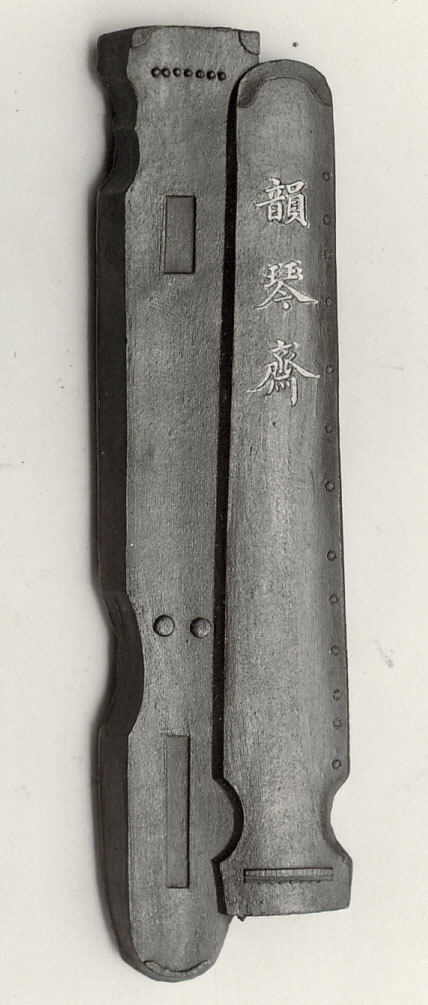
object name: ink tablet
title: Ink tablet inscribed “Melodious Harp Studio”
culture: chinese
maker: jian guzhai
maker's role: artist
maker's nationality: chinese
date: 1801-1900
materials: gilt, wood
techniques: bookbinding